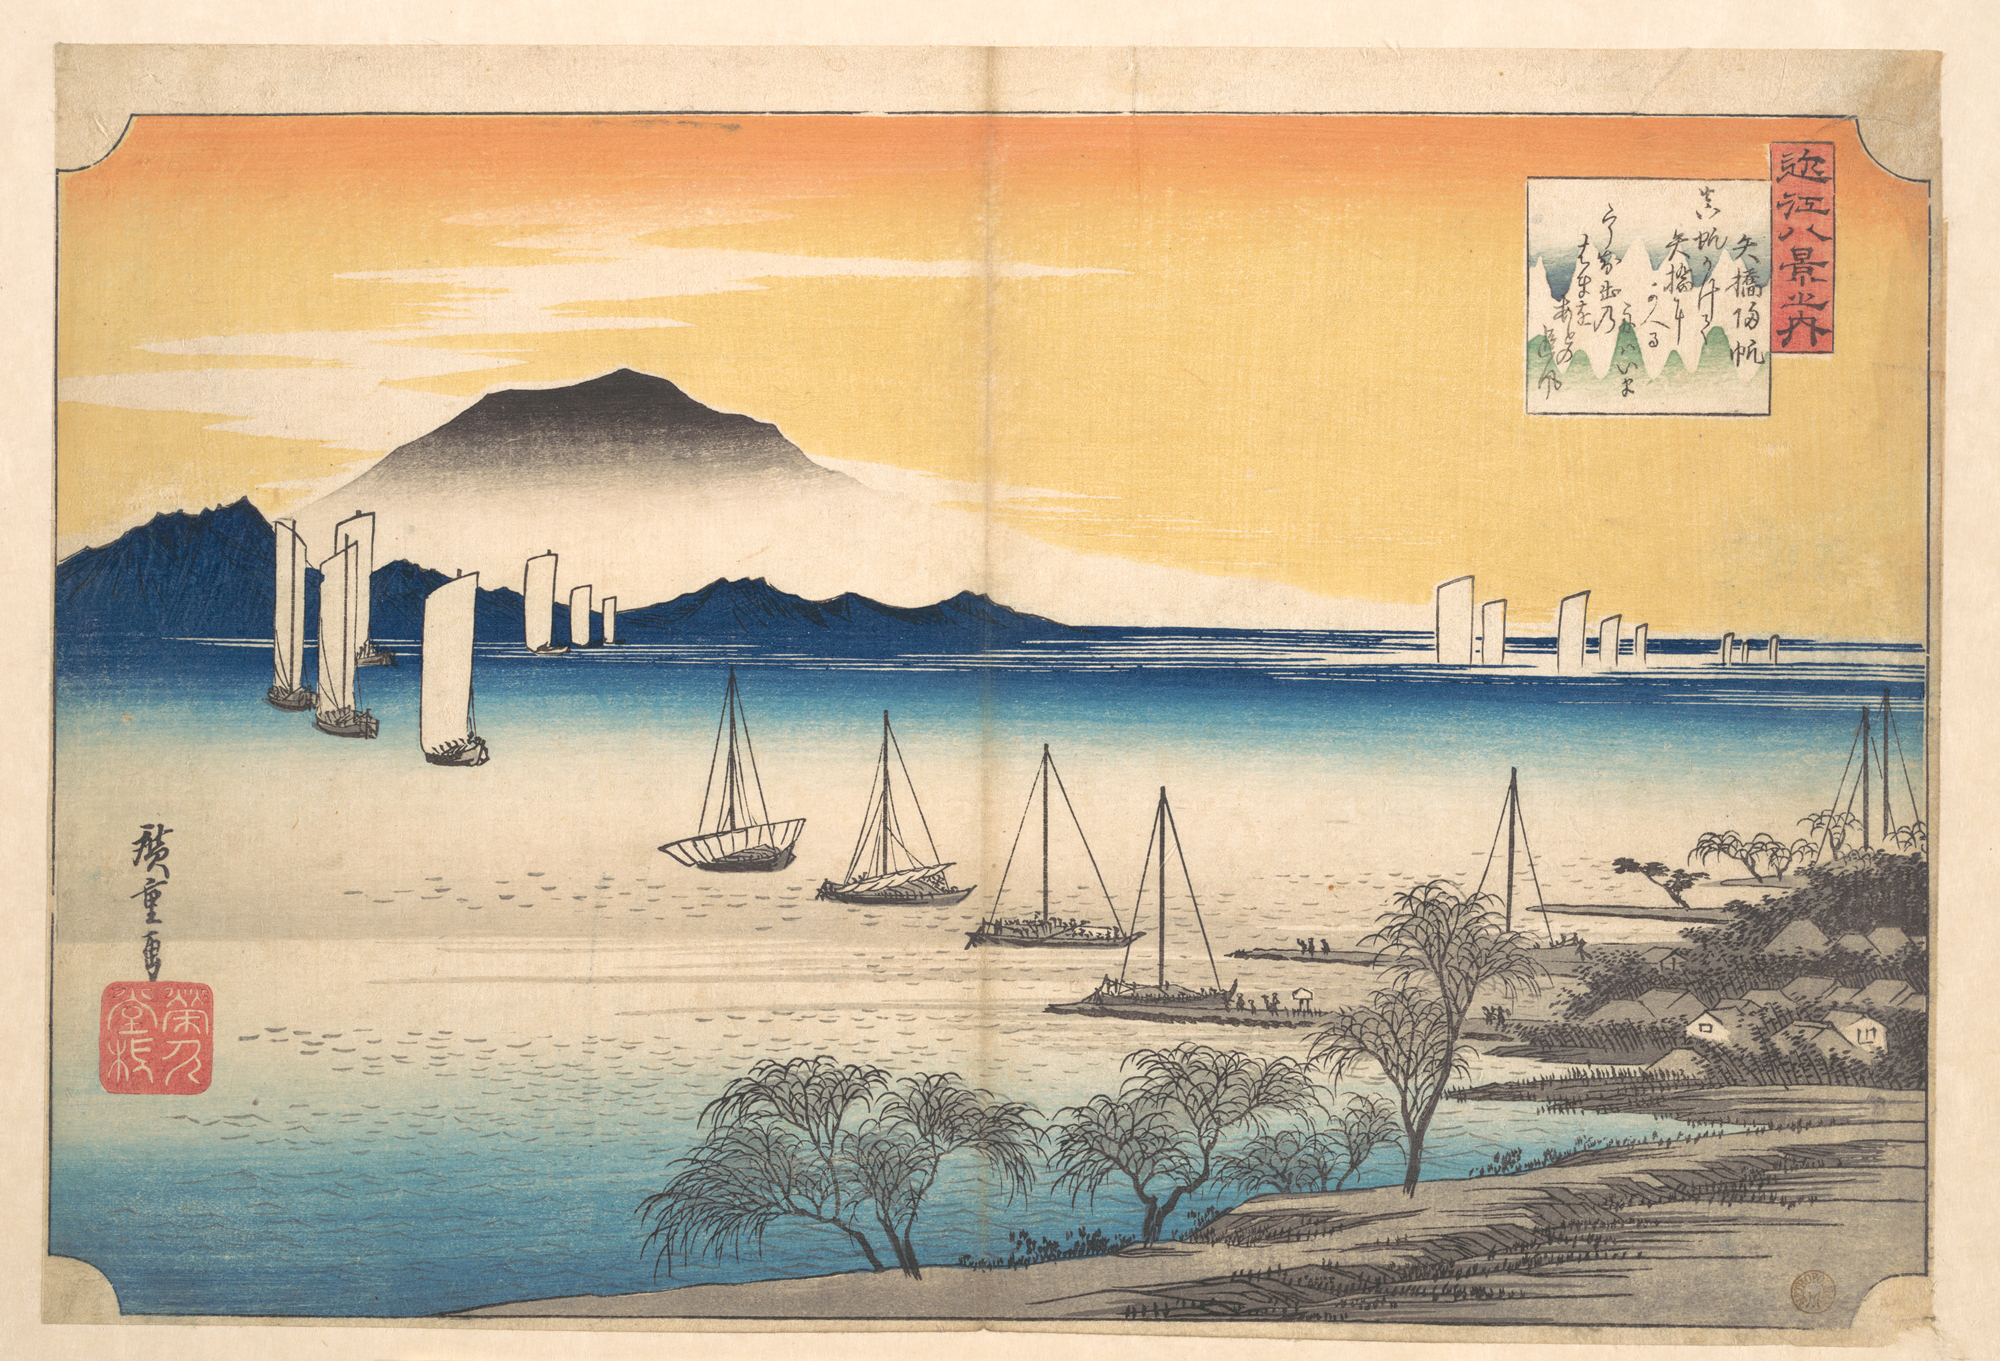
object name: woodblock print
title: Sailing Boats Returning to Yabase, Lake Biwa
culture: japanese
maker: utagawa hiroshige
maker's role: artist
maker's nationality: japanese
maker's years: 1797-1858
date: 1835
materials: ink, paper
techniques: woodblock print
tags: lakes,mountains,trees,boats